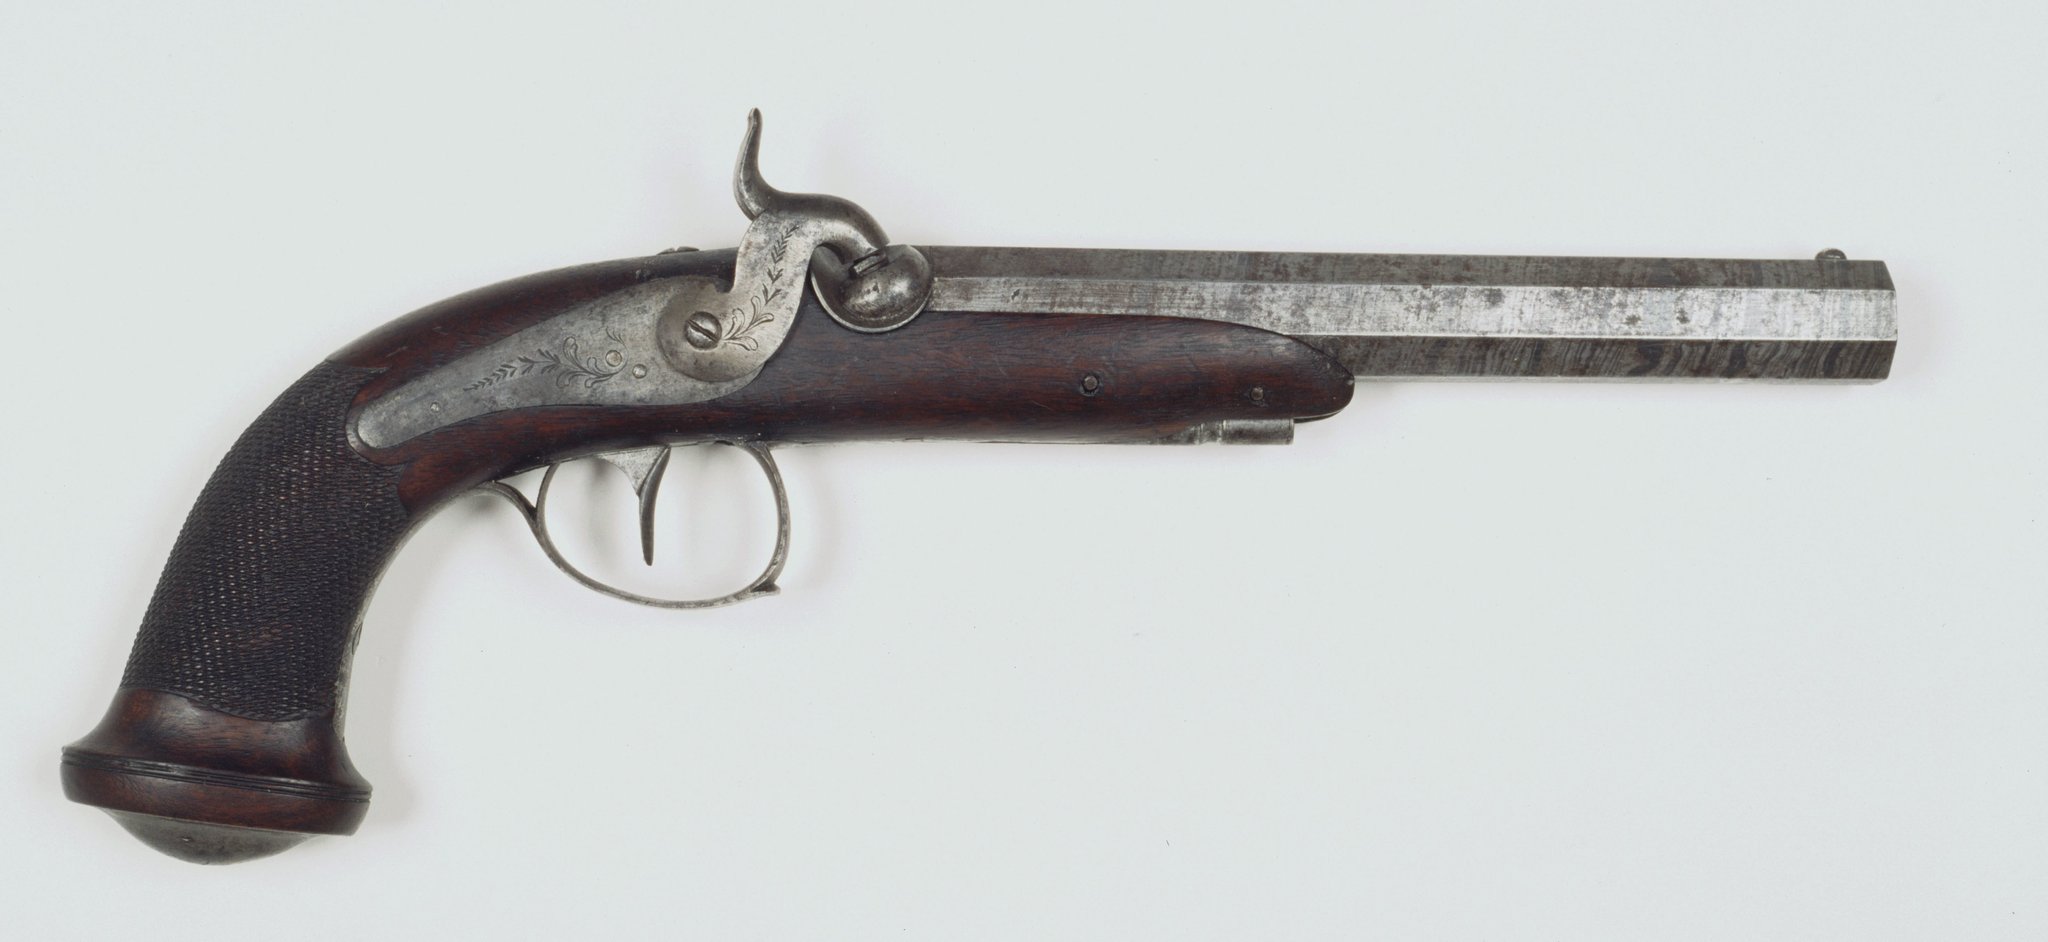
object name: percussion pistol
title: Percussiepistool met achthoekige loop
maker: Anonymous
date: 1820-1840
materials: iron, wood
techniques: engraving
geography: europe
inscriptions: mark: ‘ELG’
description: Percussiepistool met een achthoekige getrokken loop. Notenhouten halve lade en kolf welke ruitvormig gegroefd is. Op de kolf een ijzeren kolfkap welke is gegraveerd met een rankmotief. Het ijzeren slot en de haan zijn versierd met gegraveerde ranken. De trekkerbeugel is van ijzer en is versierd met bloemmotieven, het beslag onder de lade is eveneens versierd met gegraveerde bloemmotieven. De laadstokkoker onder de lade is van ijzer, laadstok ontbreekt. Aan de zijkant van de loop staat het Luikse keurmerk ELG gegraveerd. op het staartstuk een ijzeren keep en aan het uiteinde van de loop een ijzeren vizierkorrel.